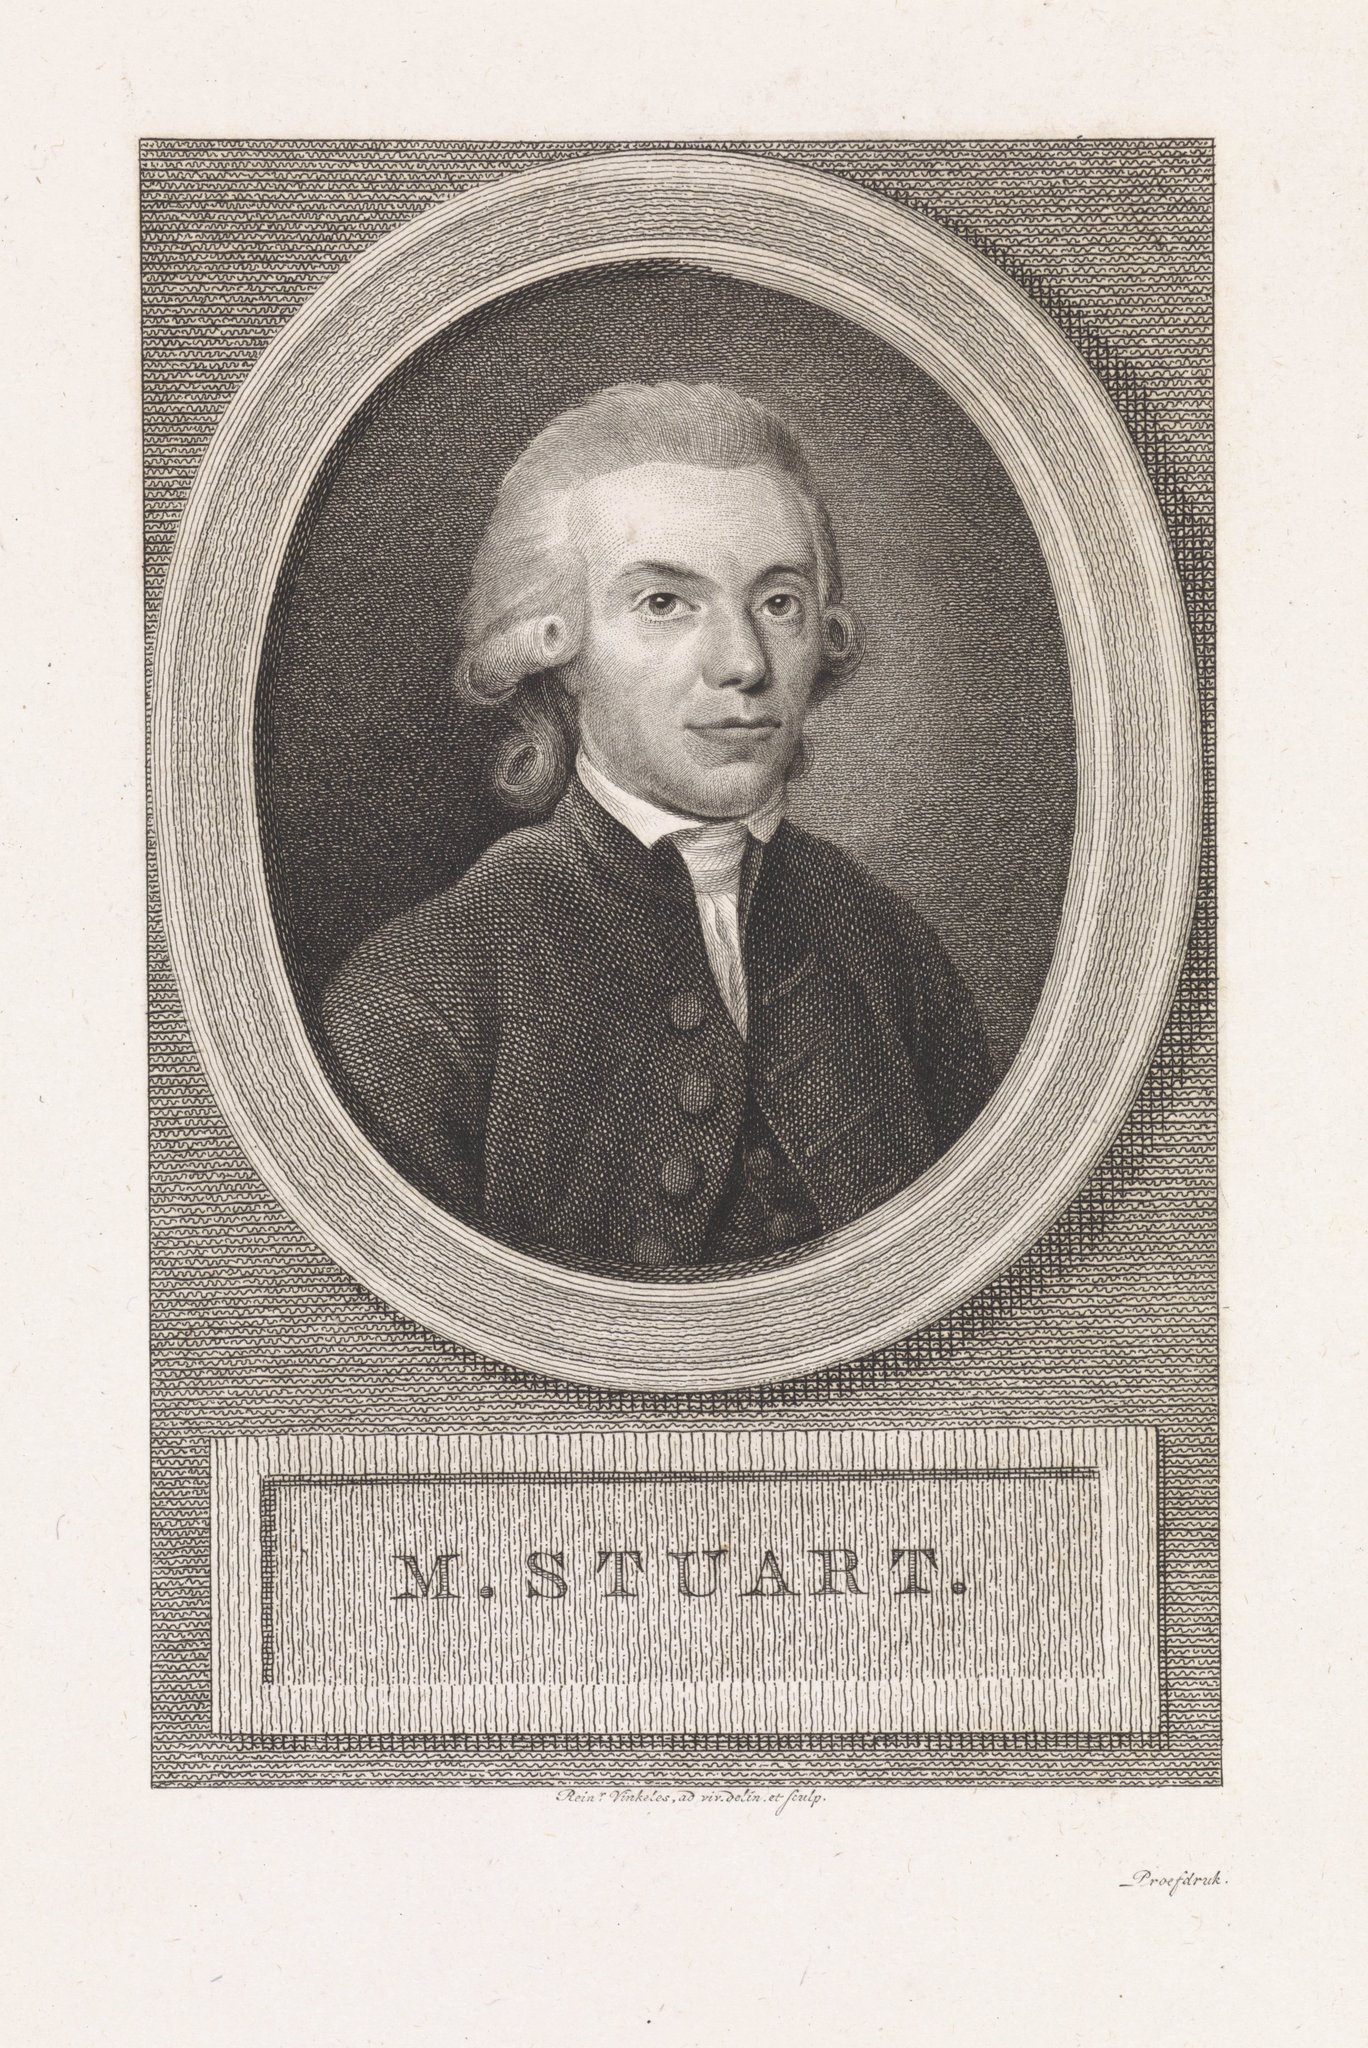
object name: print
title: Portret van Martinus Stuart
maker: reinier vinkeles (i)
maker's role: draughtsman, print maker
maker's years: 1741-1816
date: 1793-1816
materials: paper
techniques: engraving, etching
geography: amsterdam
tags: rotterdam, amsterdam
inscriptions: collector's mark: Lugt 2228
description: Portret van Martinus Stuart, predikant en schrijver te Amsterdam.